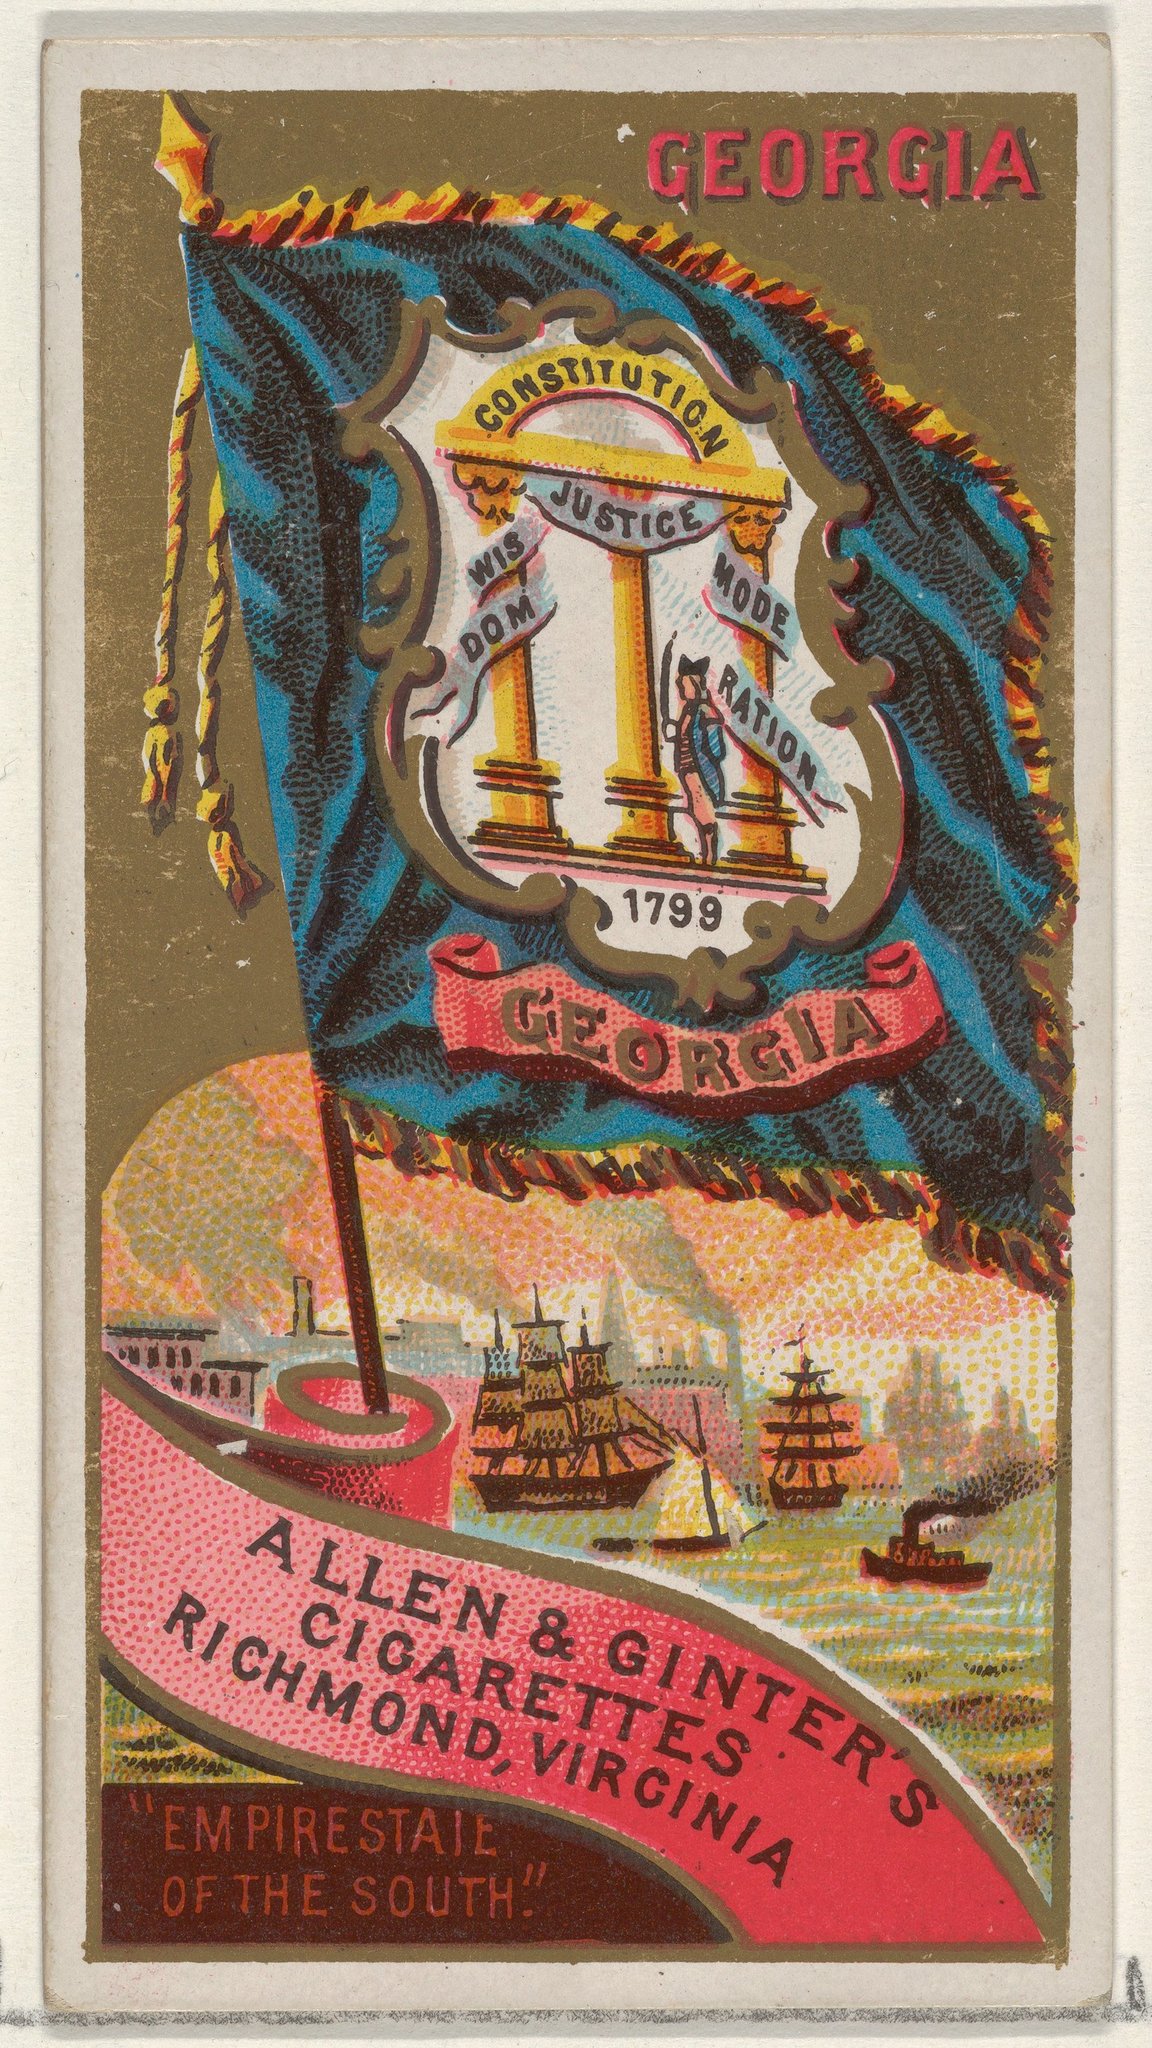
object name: print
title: Georgia, from Flags of the States and Territories (N11) for Allen & Ginter Cigarettes Brands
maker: allen & ginter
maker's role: publisher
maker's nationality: american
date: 1888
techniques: color lithograph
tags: flags